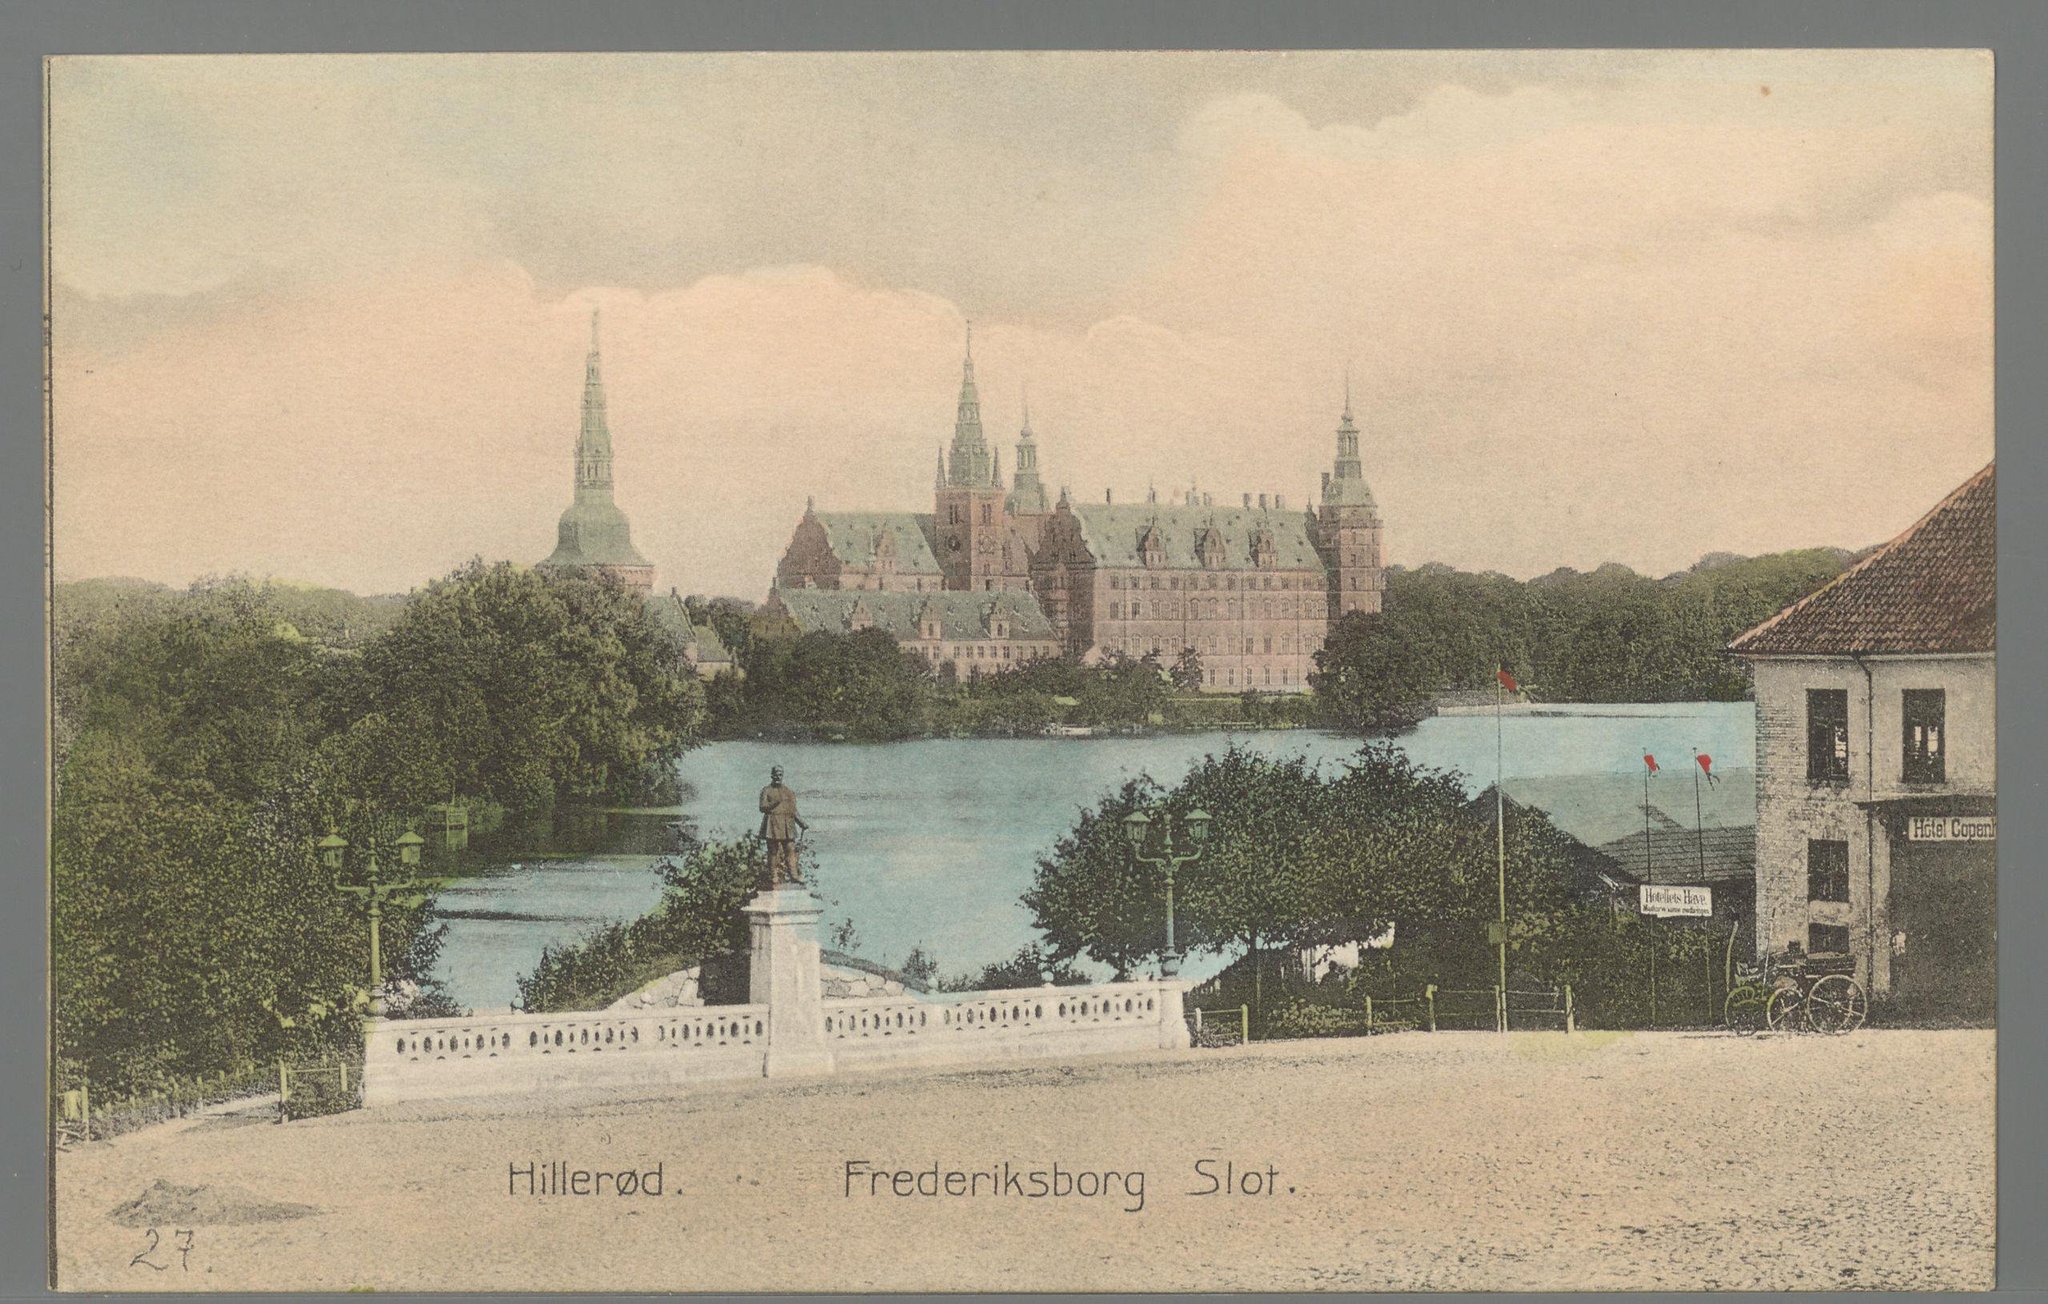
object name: photomechanical print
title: Hillerød. Frederiksborg Slot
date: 1906-1920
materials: cardboard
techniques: photograph, lithograph, hand coloring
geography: copenhagen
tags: park, palace, pond, pool